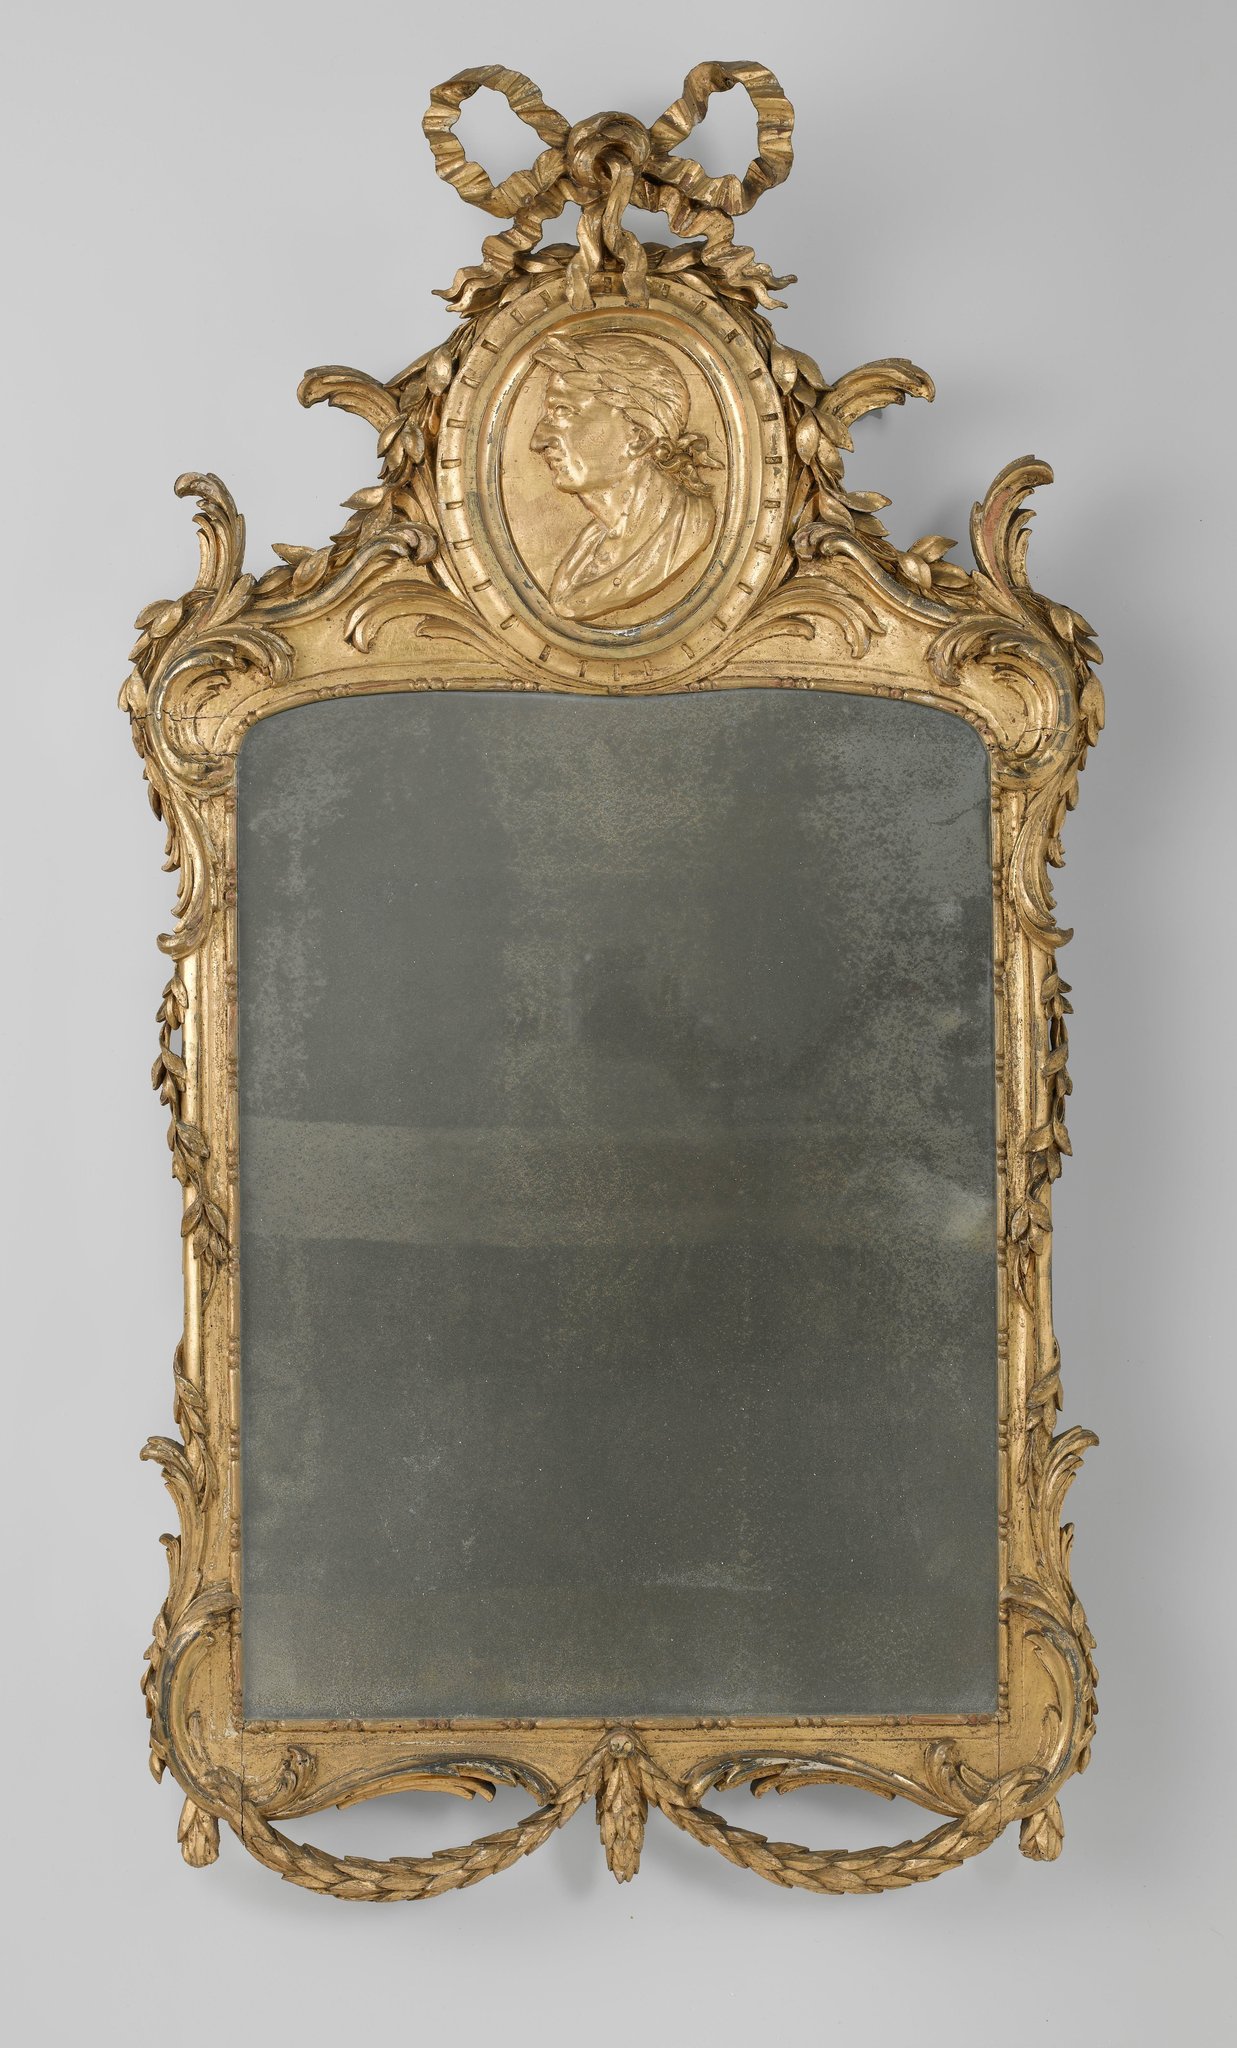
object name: furniture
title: Spiegel in vergulde en gesneden lijst met o.a. een ovaal medaillon met een naar links gewende gelauwerde mannenkop als wapenstuk van de familie 't Hooft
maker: Anonymous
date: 1780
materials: amalgam, wood, glass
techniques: gilding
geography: northern netherlands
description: Looking glass with frame, gilded limewood, Netherlands, c. 1770 - 1780. Given by Mr C.G. 't Hooft and Mrs E.P. van Linden-'t Hooft, 1961.